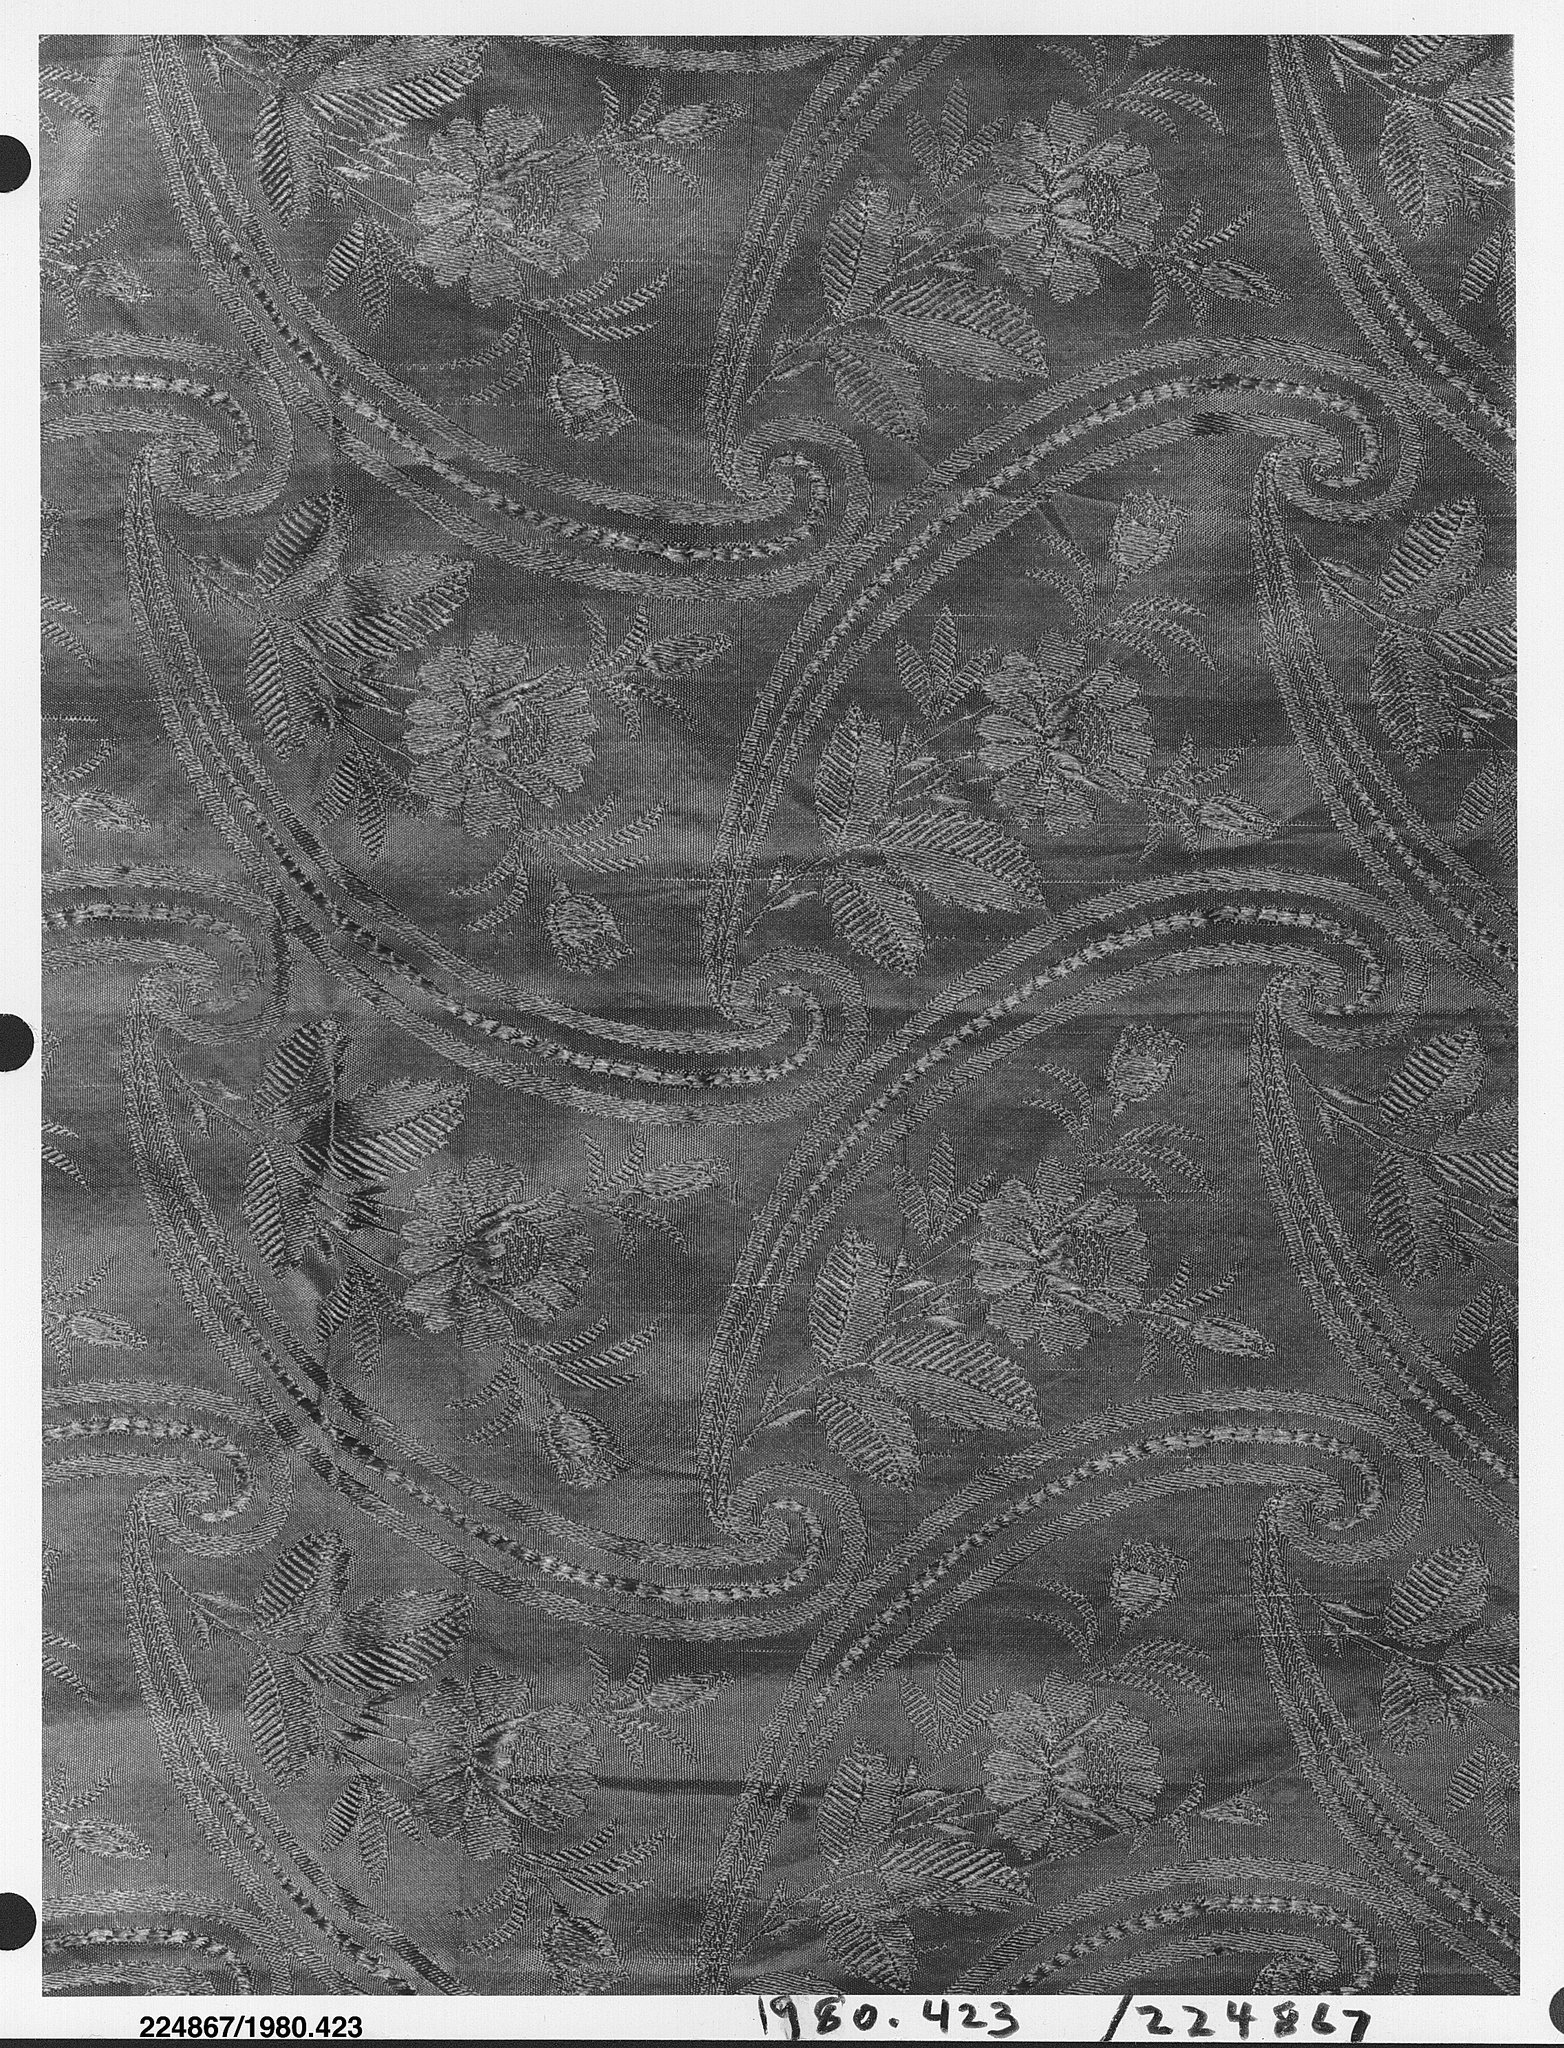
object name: piece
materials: silk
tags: flowers,leaves